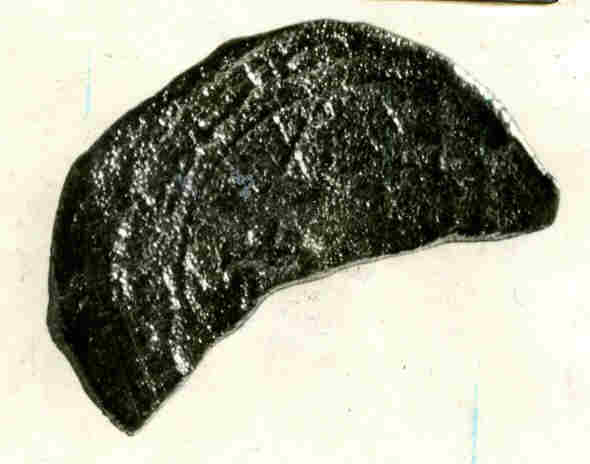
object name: coin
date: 701-800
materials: copper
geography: iran